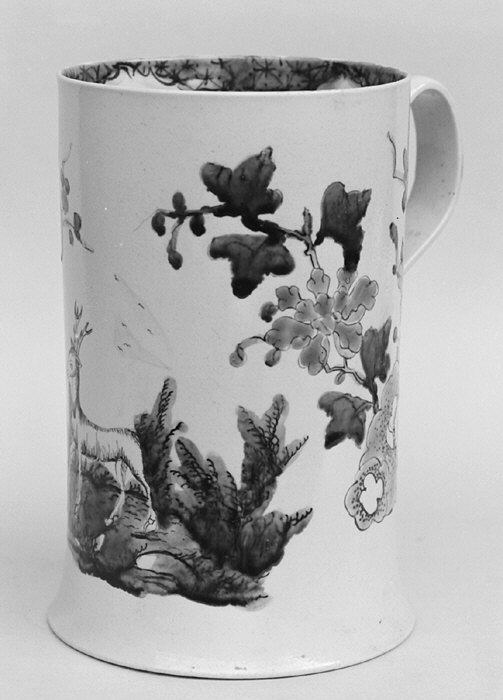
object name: mug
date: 1760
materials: stoneware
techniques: salt glaze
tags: deer